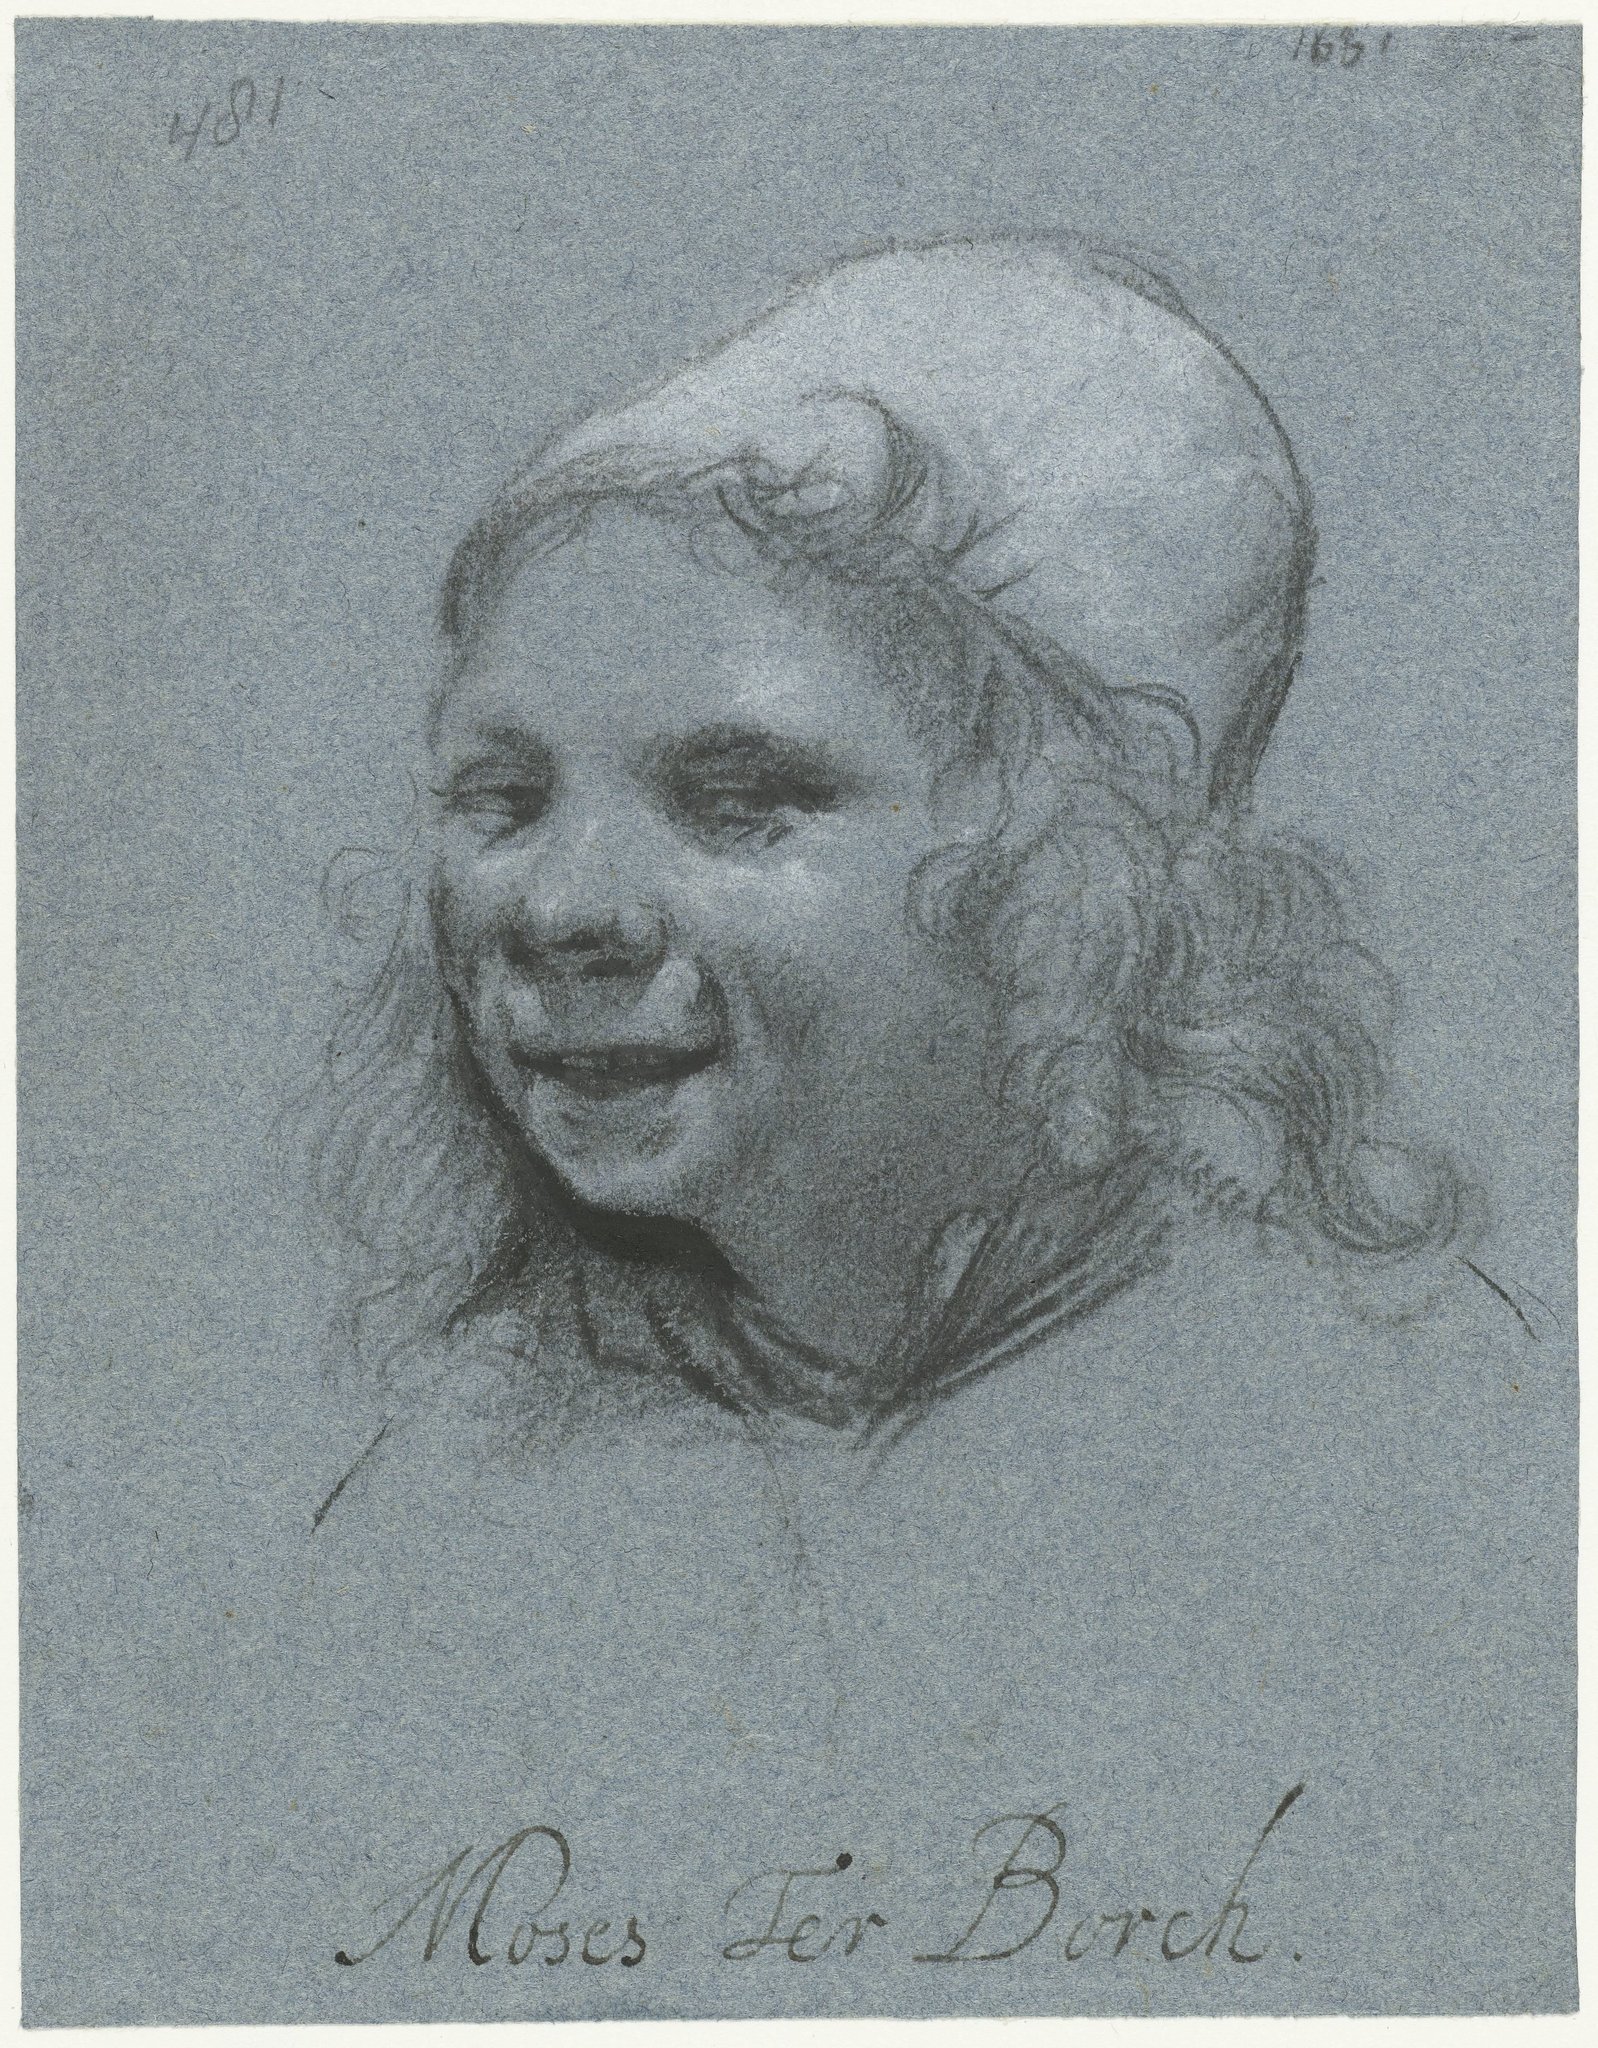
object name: watercolor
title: Smiling Self-portrait, from the Side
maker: moses ter borch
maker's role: draughtsman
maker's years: 1645-1667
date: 1661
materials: chalk, ink, paper, watercolor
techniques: brush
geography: zwolle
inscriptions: signature and date: ‘Moses ter Borch; 1661’, annotation: ‘21’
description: Moses ter Borch was one of the few artists in the second half of the 17th century who, inspired by Rembrandt’s self-portraits, frequently studied his own face. The young artist recorded himself with different expressions in these three studies. Thus he is not looking out at us, but rather examining his reflection in a mirror.